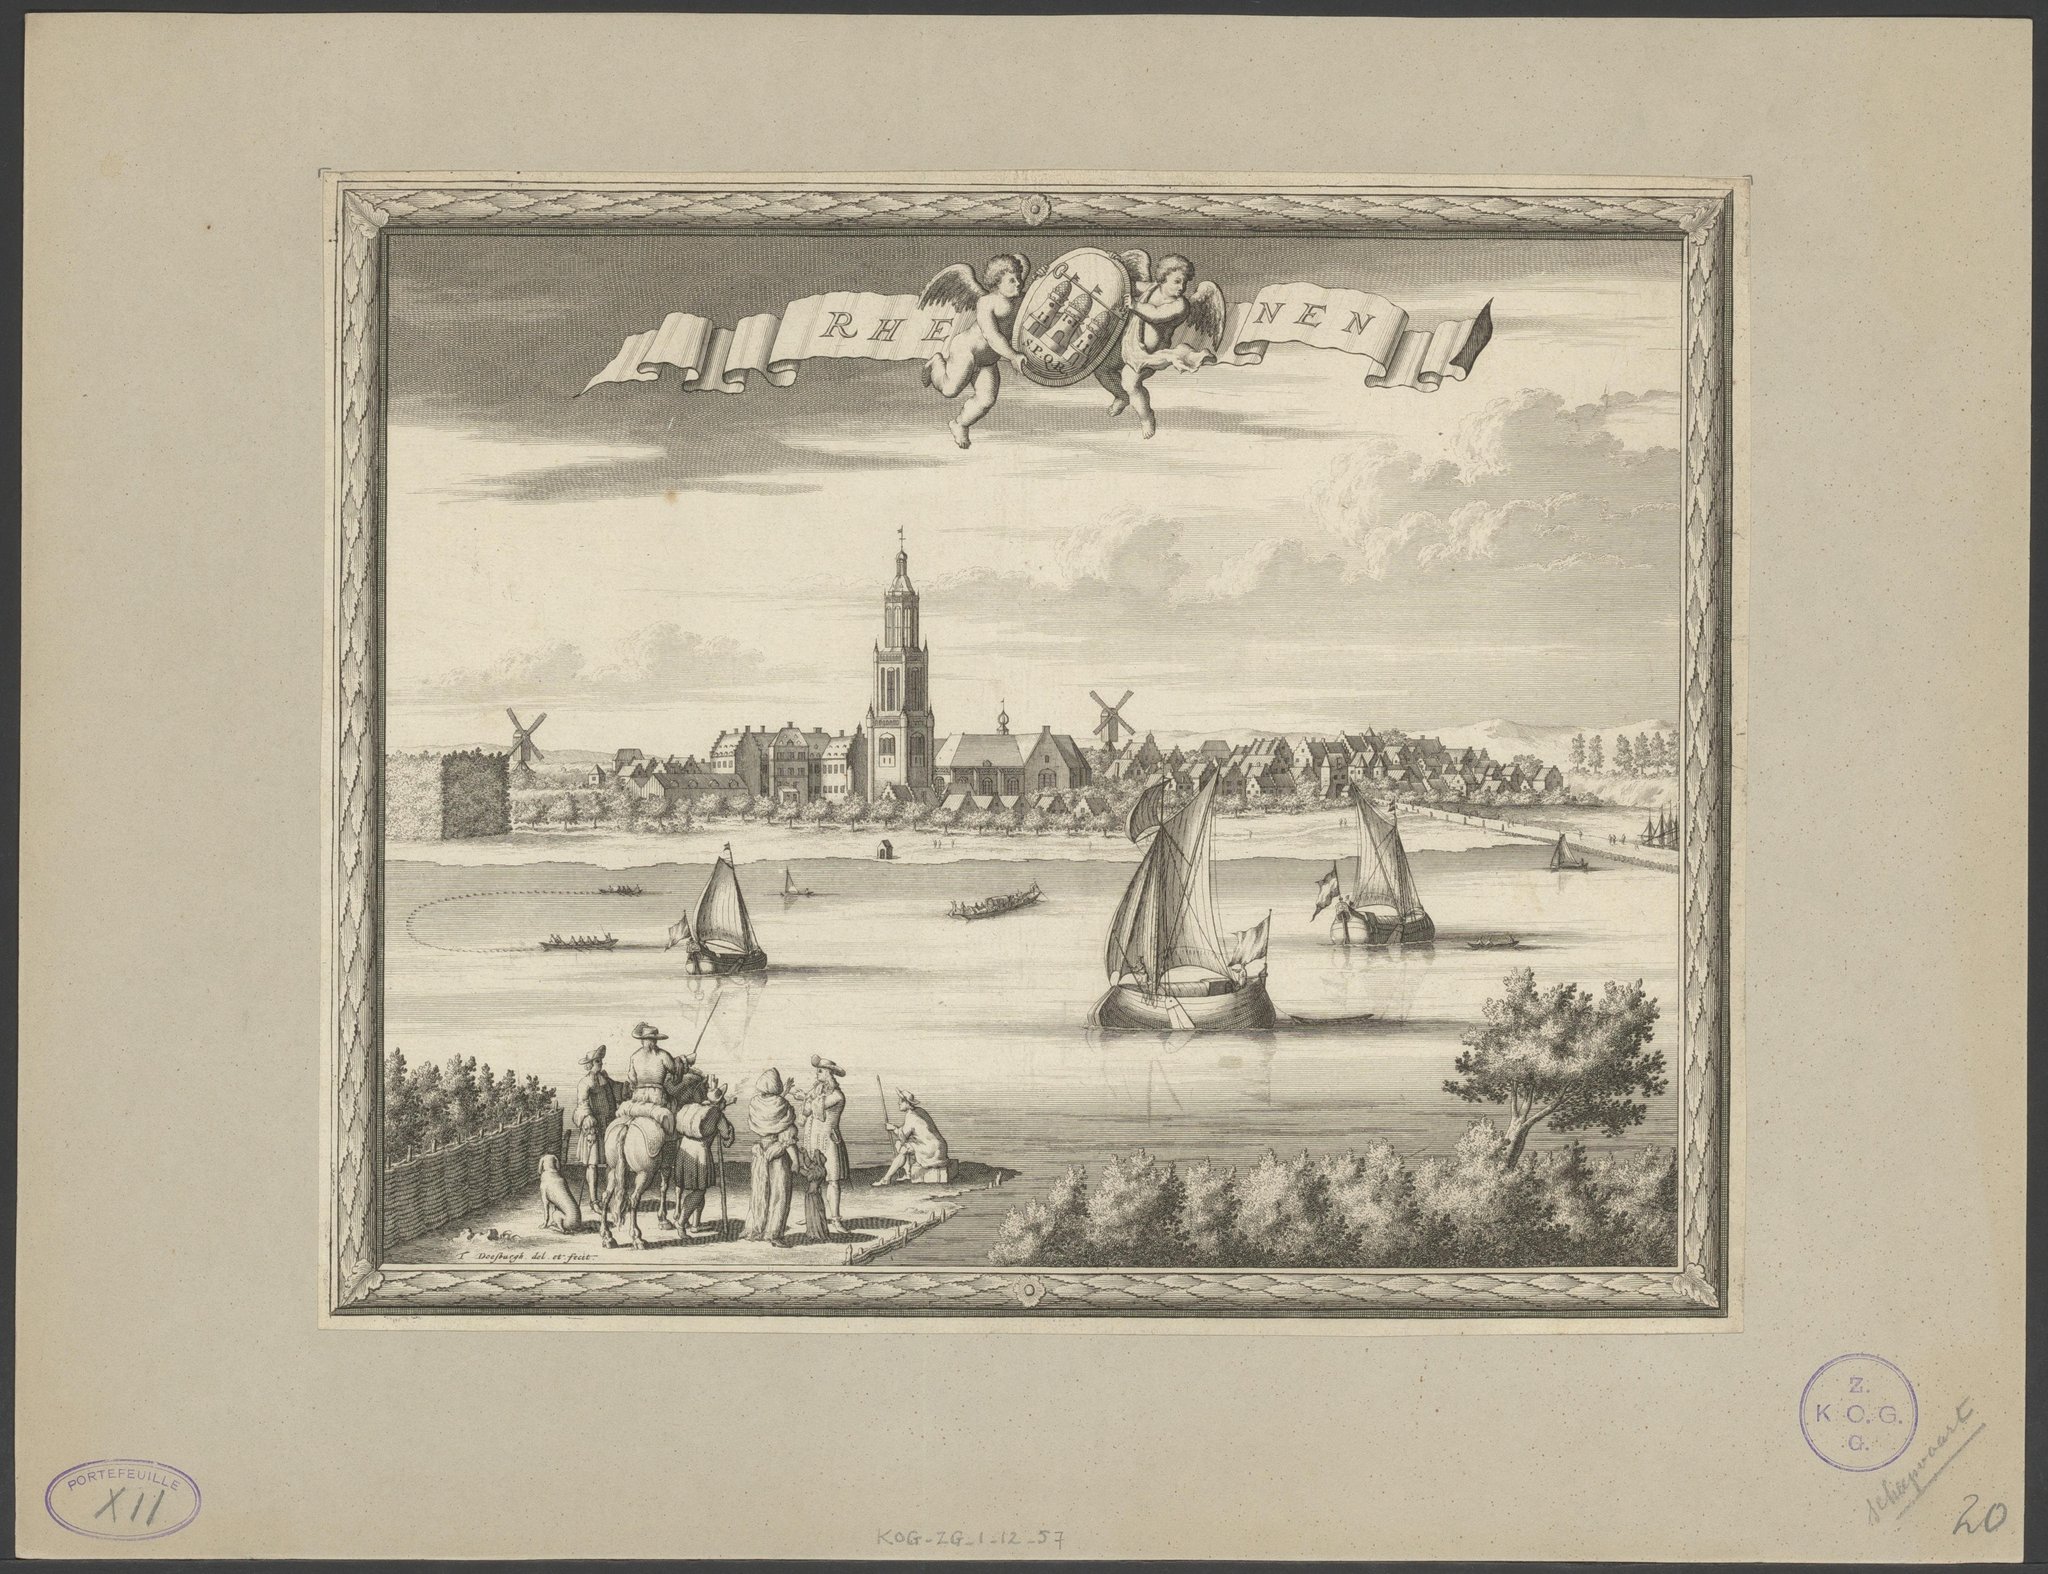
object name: print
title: Gezicht op Rhenen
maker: thomas doesburgh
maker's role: print maker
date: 1683-1714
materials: paper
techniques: etching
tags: church (exterior), ships (in general) - cc - more than one ship, cupids: 'amores', 'amoretti', 'putti', prospect of city, town panorama, silhouette of city, armorial bearing, heraldry, rhenen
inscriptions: stamp, collector's mark: Lugt 1641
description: Gezicht op Rhenen met de toren van de Cunerakerk, gelegen op de oever van de Nederrijn. Bovenaan een banier met naam van de stad. In het midden van de banier houden twee putti een wapenschild op. Onderwerpsrubrieken binnen de Atlas Zeden en Gewoonten: Handel, Nijverheid en Verkeer, Scheepsvaart.